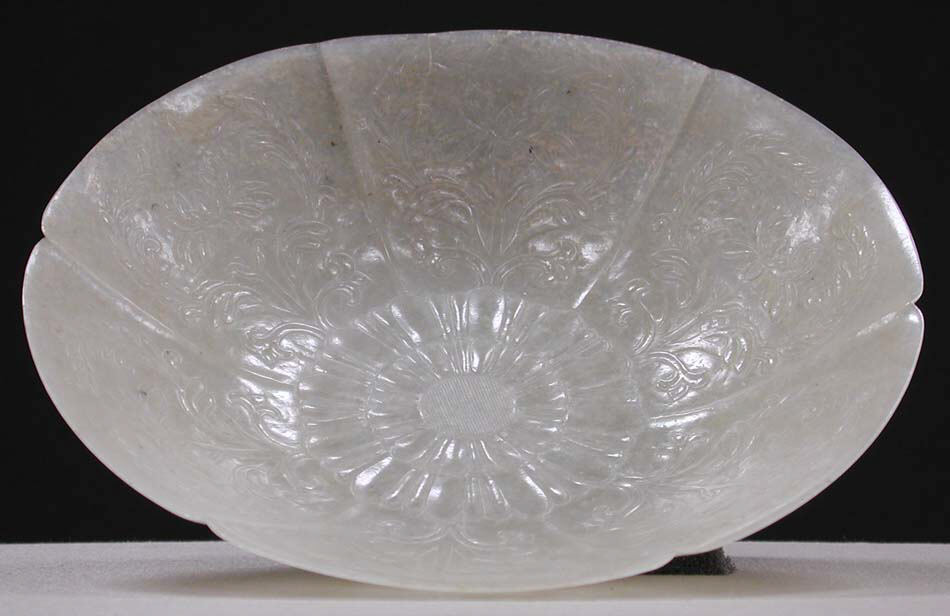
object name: bowl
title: Shallow bowl in the shape of a flower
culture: indian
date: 1601-1800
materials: jade